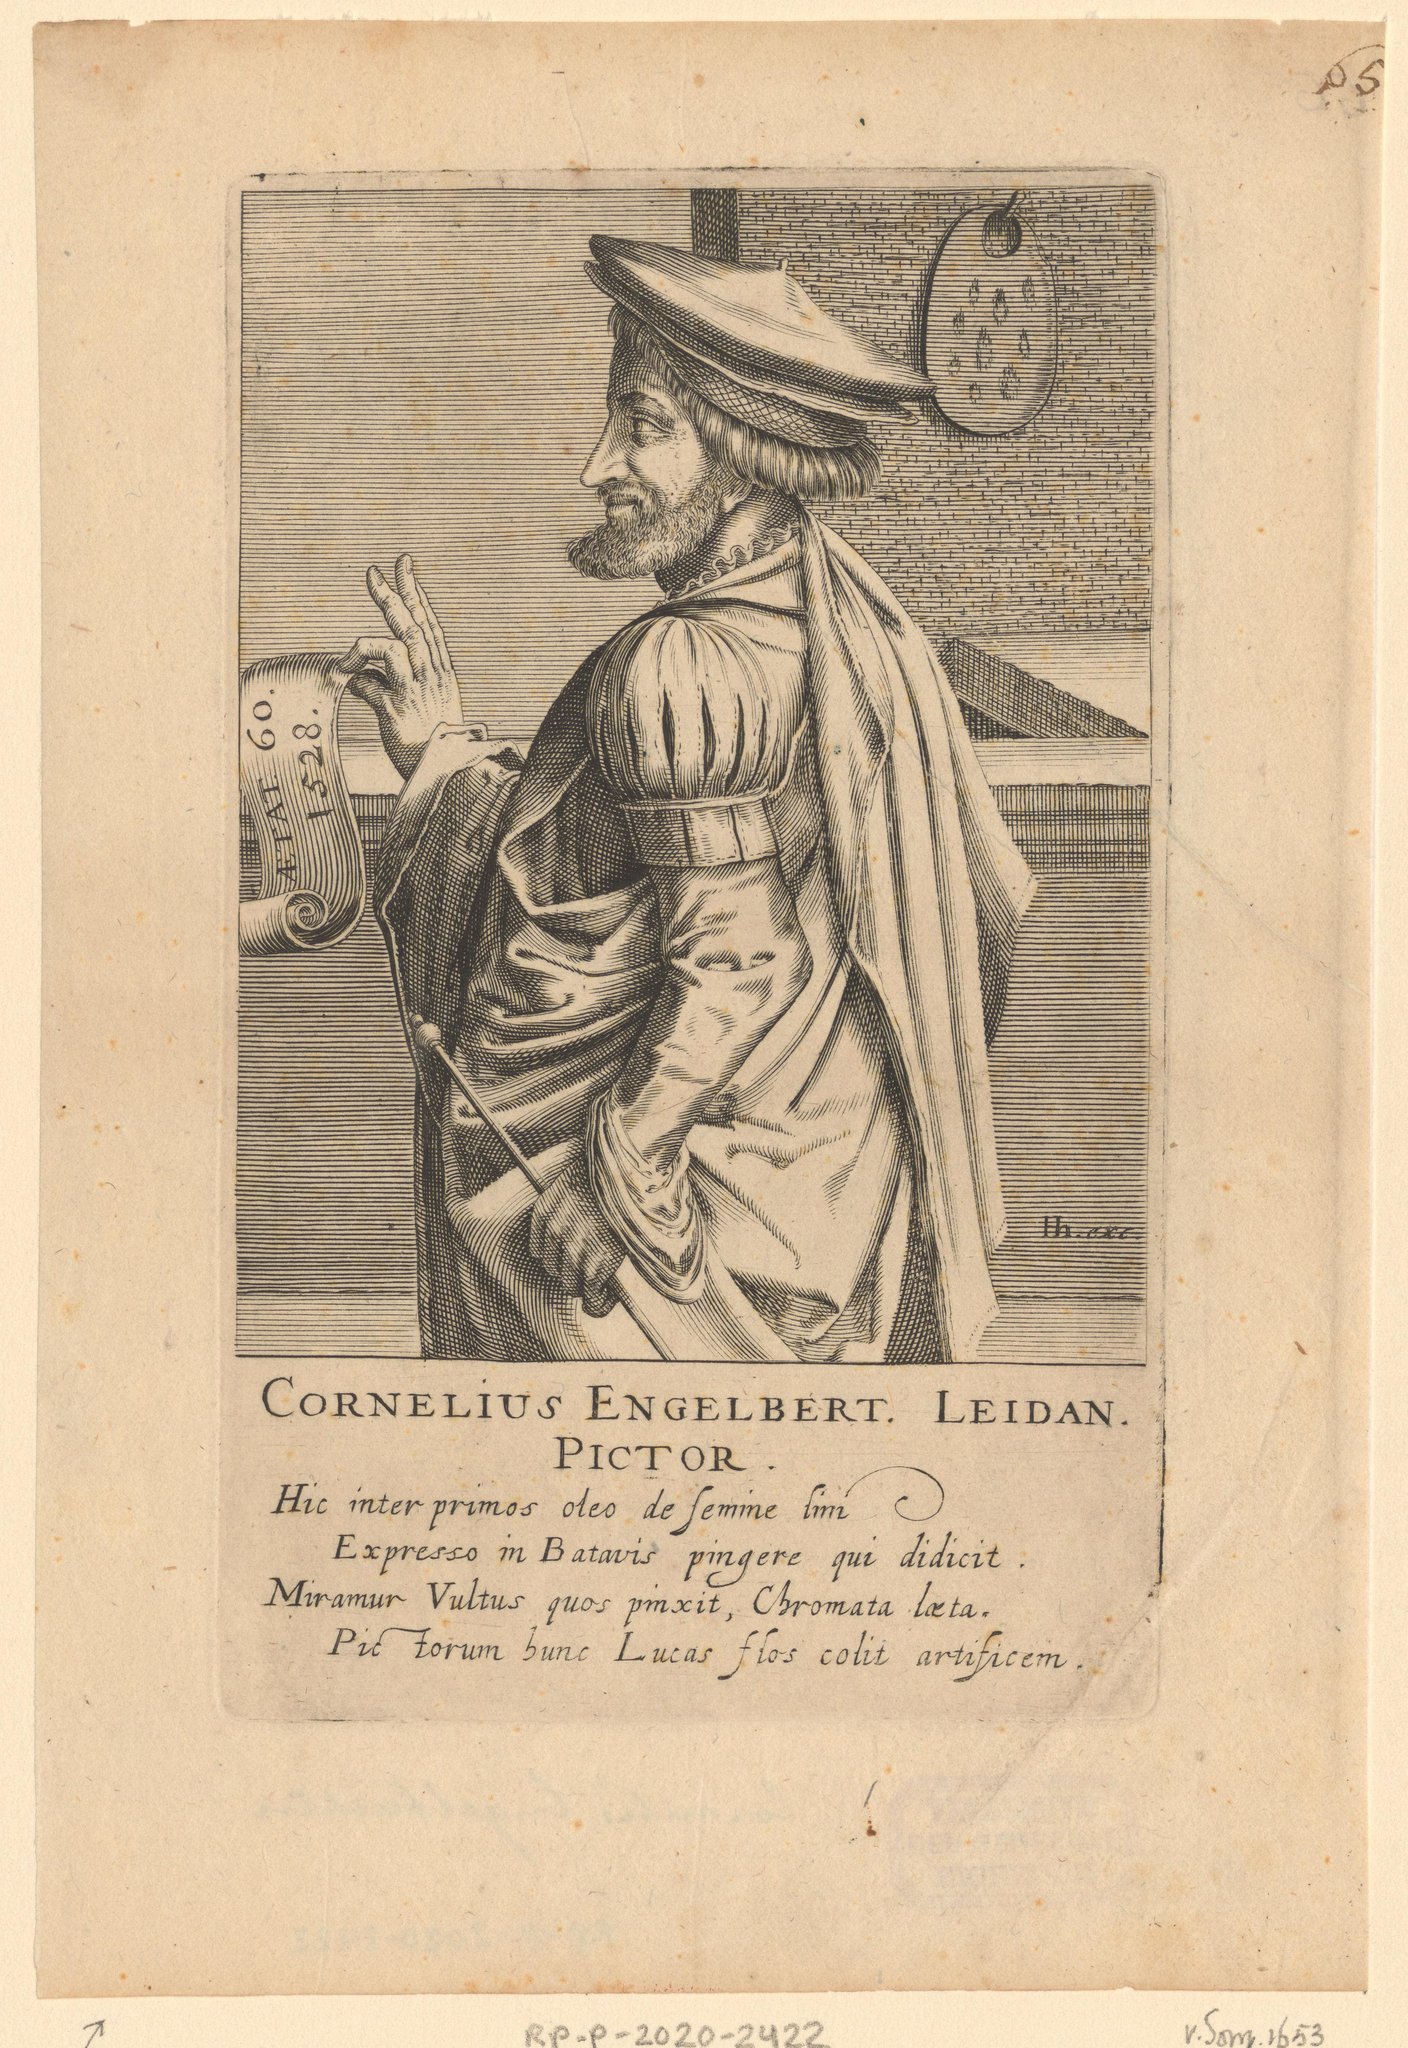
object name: print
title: Portret van Cornelis Engebrechtsz. op 60-jarige leeftijd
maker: hendrick hondius (i)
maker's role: draughtsman, print maker, publisher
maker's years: 1573-1650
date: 1610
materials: paper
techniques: engraving, etching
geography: the hague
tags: leiden, painter, draughtsman, cornelis engebrechtsz, historical persons, portrait, self-portrait of painter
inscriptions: collector's mark: Lugt 11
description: Prent uit deel 1 van de serie Pictorum Aliquot Celebrium Praecipuae Germaniae Inferioris Effigies. Serie van 72 kunstenaarsportretten vervaardigd door Hendrick Hondius I, Simon Frisius, Andries Jacobsz. Stock en Robert de Baudous.